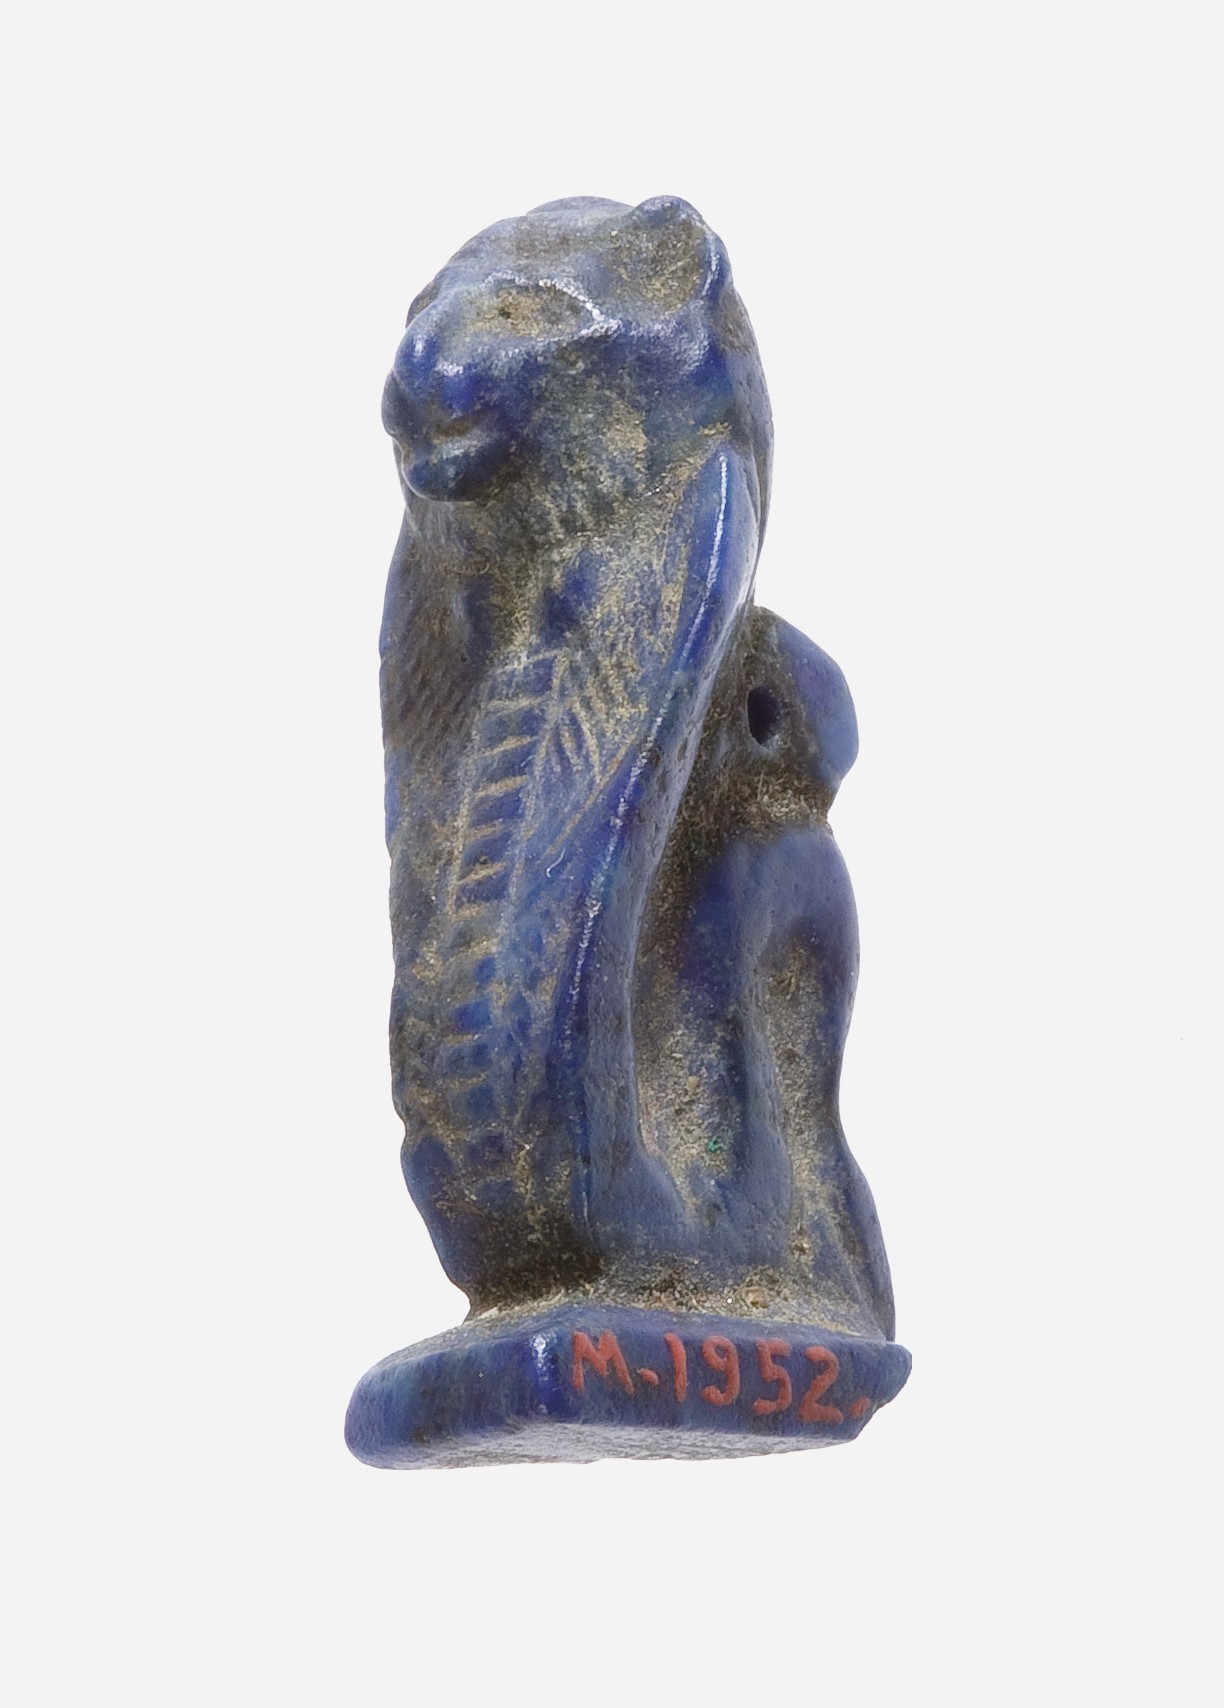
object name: amulet, cat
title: Uraeus Amulet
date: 664-332 BCE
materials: lapis lazuli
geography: egypt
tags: serpents